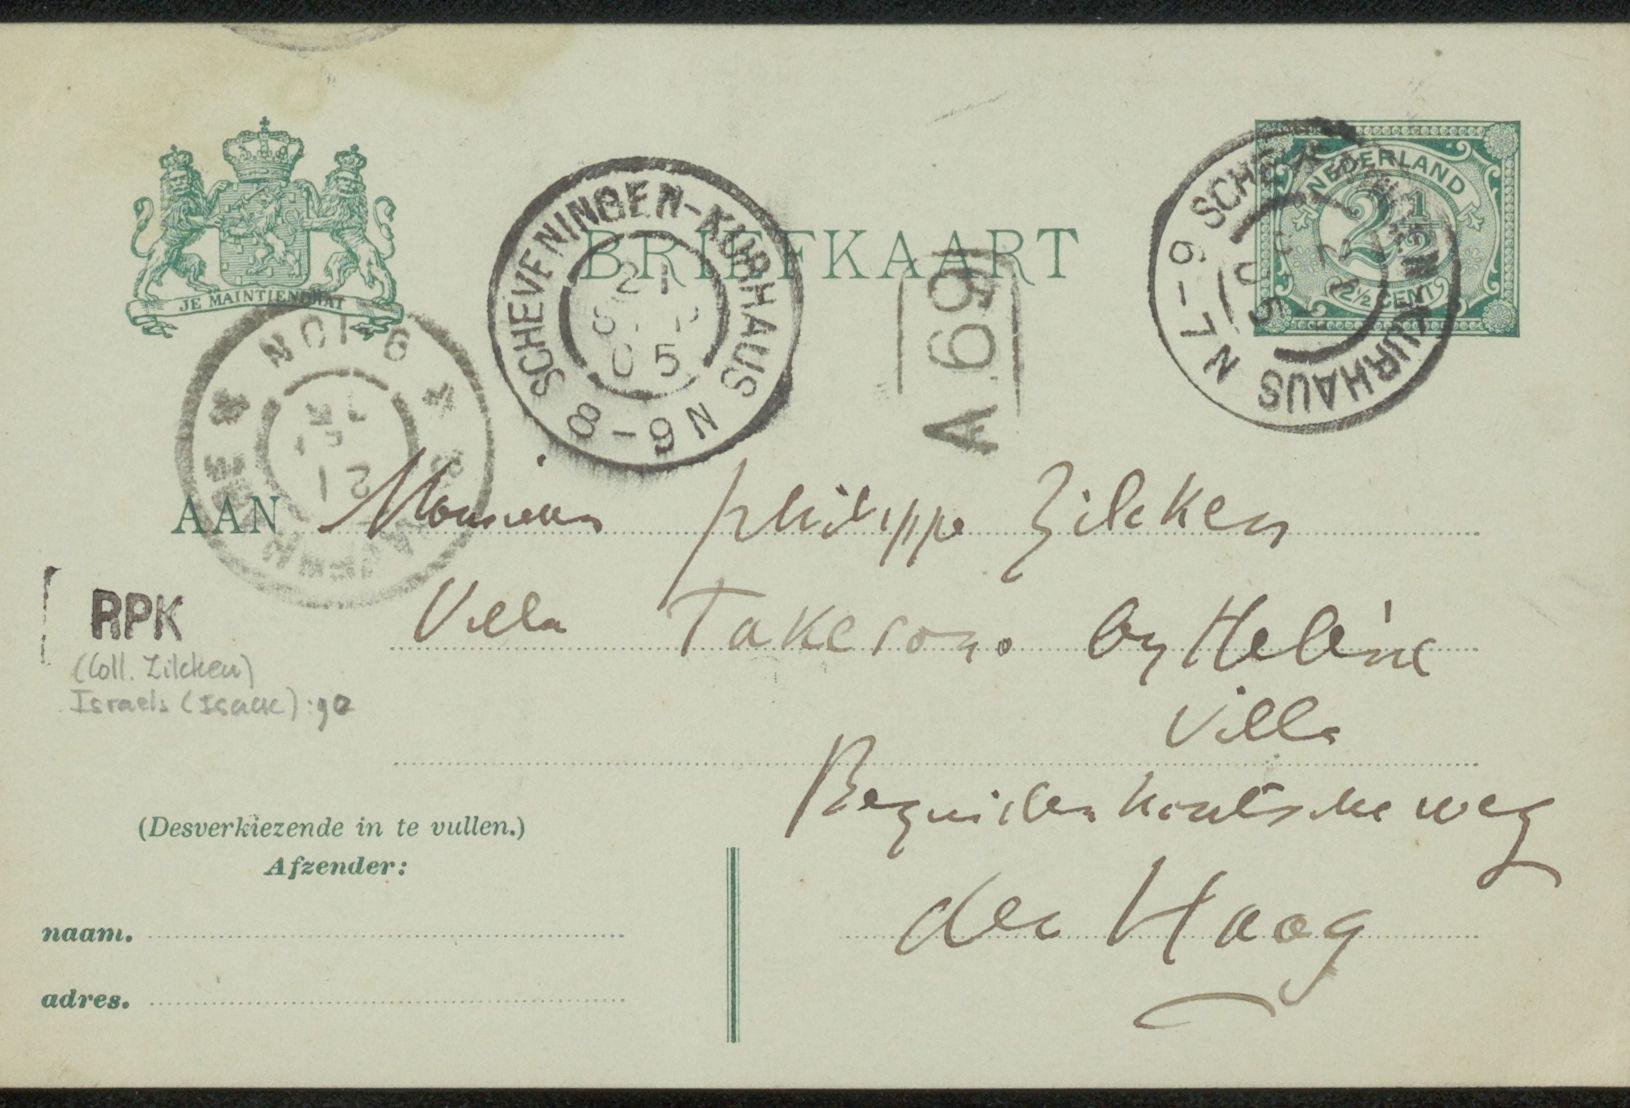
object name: postcard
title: Briefkaart aan Philip Zilcken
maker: isaac israels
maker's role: draughtsman, painter, print maker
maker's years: 1865-1934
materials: cardboard, ink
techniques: writing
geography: scheveningen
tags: the hague, painter, print maker, draughtsman, jozef israëls, philip zilcken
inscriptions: collector's mark: ‘RPK’